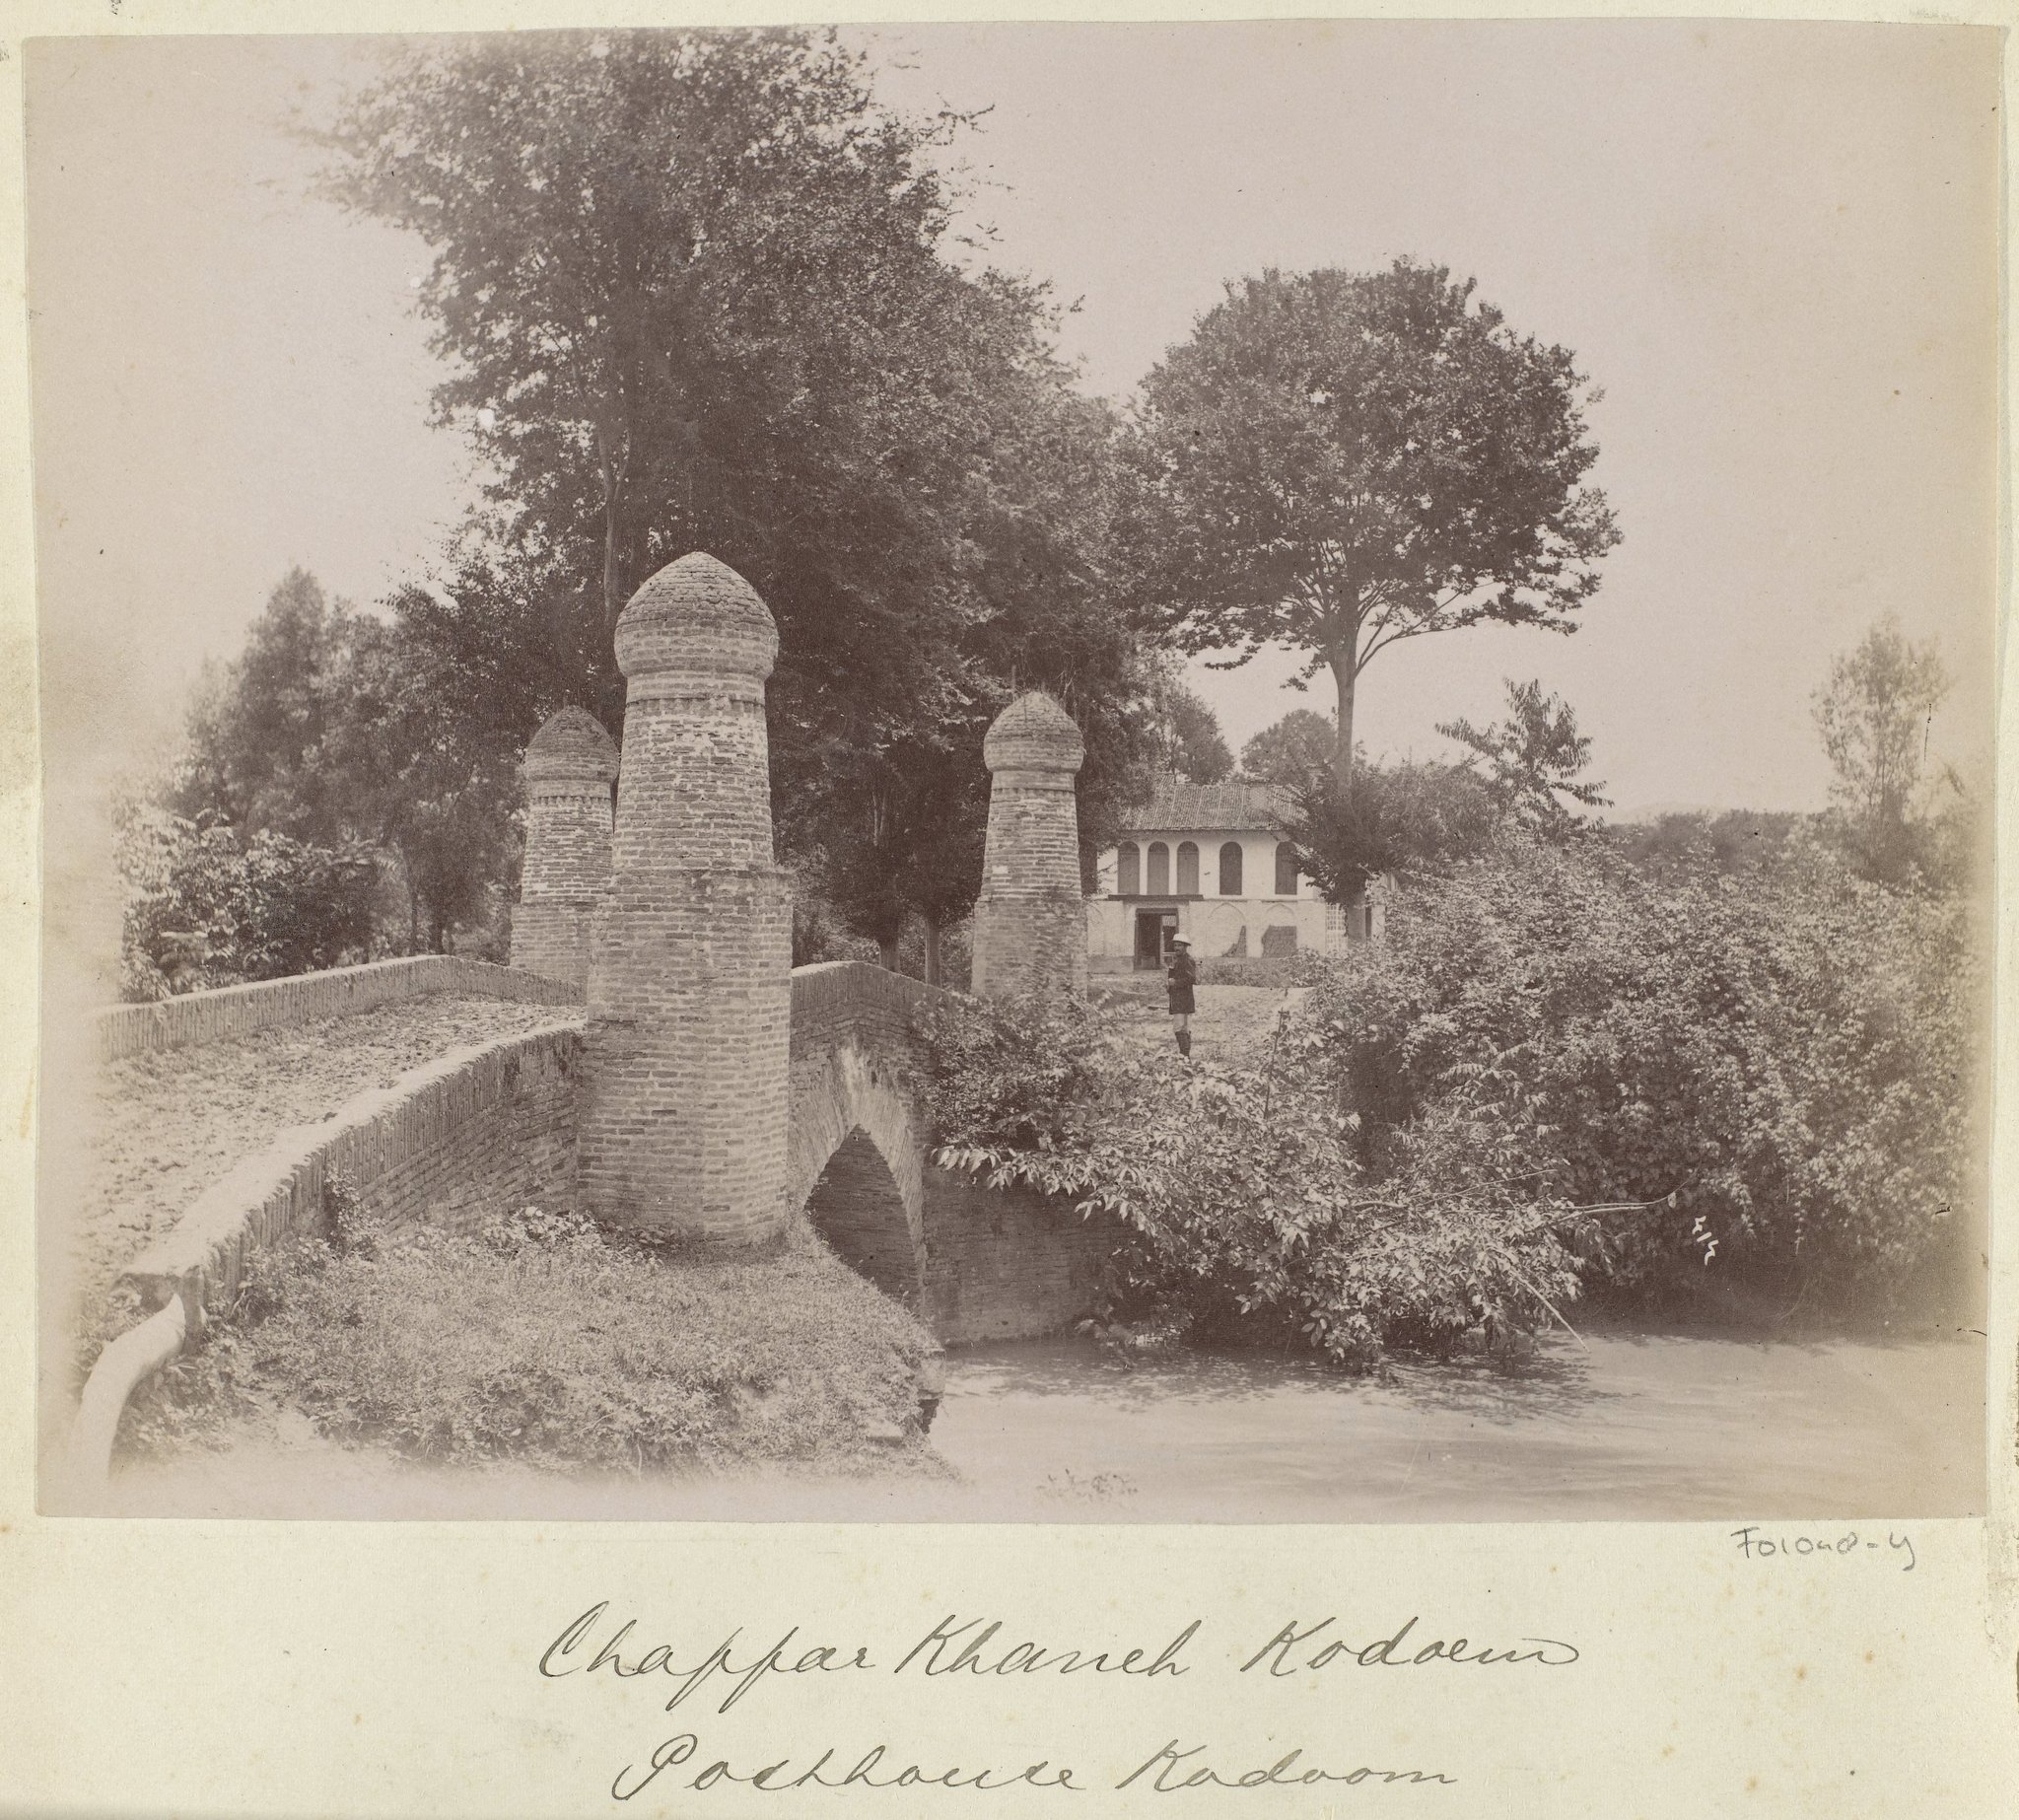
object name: photograph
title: Posthuis bij een stenen brug in Perzië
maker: antoine sevruguin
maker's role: fotograaf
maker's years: 1840-1933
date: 1880-1895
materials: paper, photographic support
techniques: albumen print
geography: iran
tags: post-office, bridge, persia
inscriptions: negative number: ‘414’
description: Onderdeel van Reisalbum van H. Dunlop met foto's van bezienswaardigheden in Perzië, Schotland, Duitsland, Rusland, China en Canada.